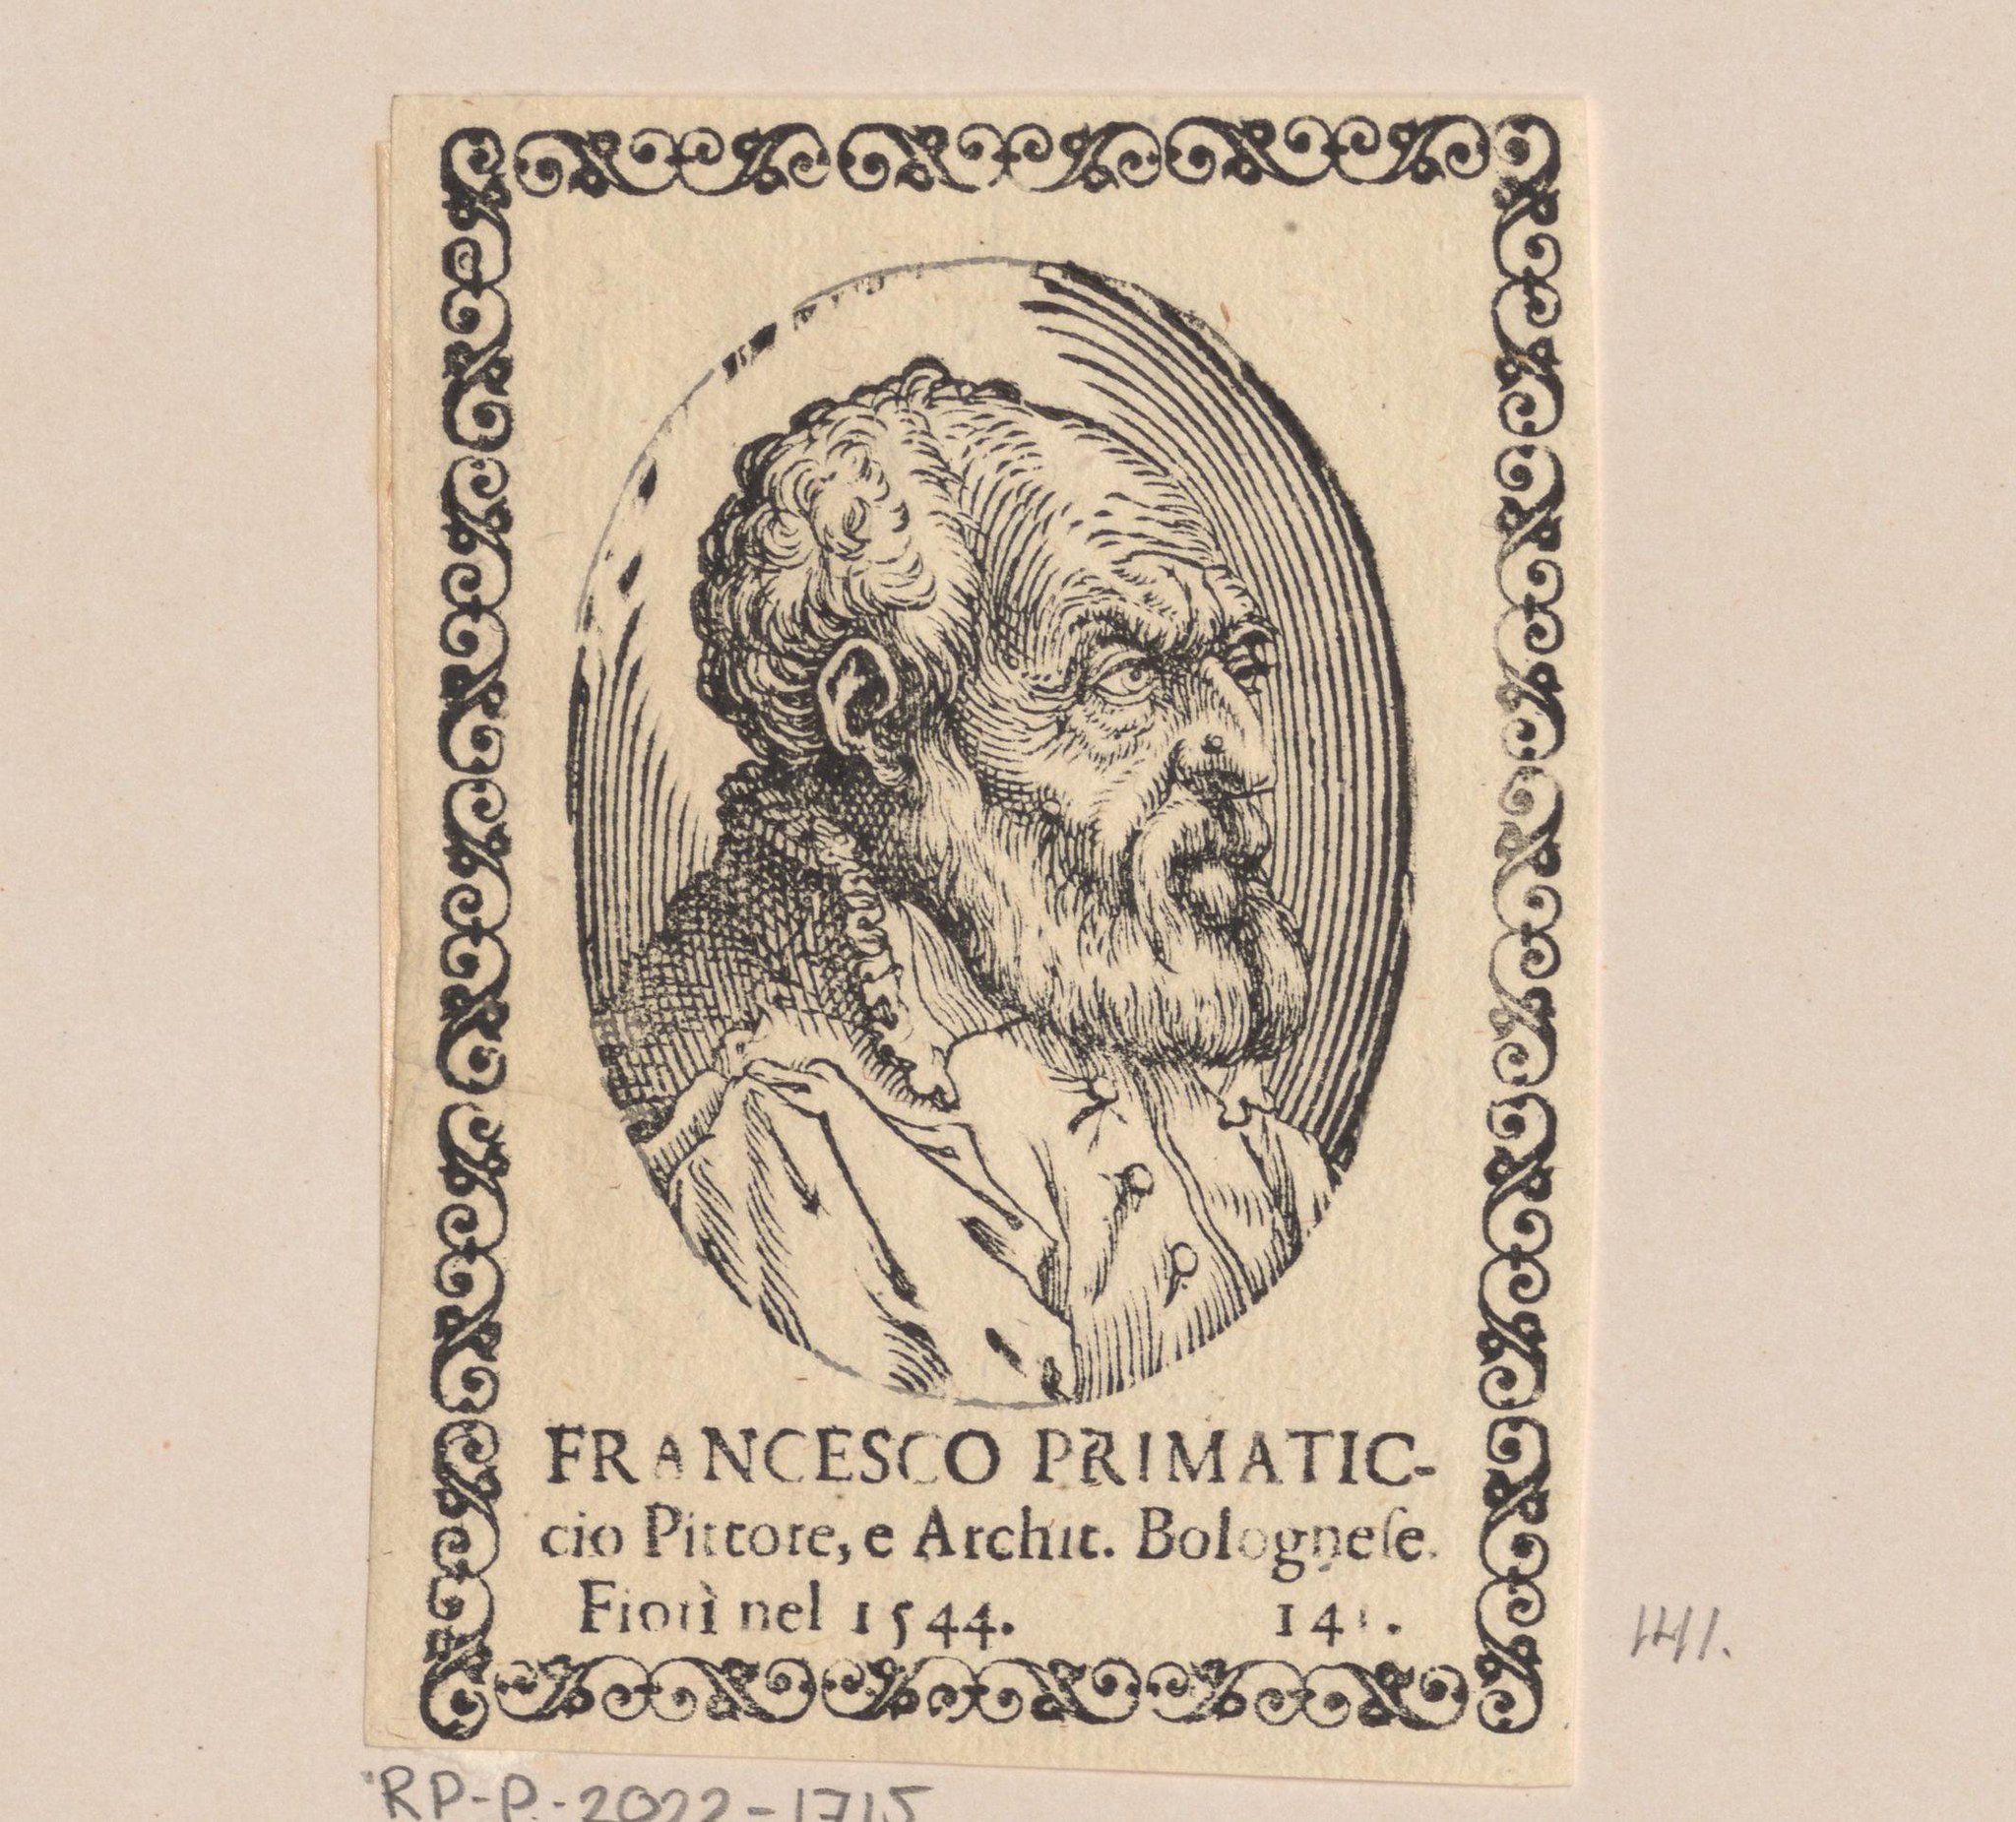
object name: print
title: Portret van Francesco Primaticcio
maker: cristoforo coriolano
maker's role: print maker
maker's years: 1540-1610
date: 1568-1650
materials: paper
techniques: letterpress printing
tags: paris, painter, draughtsman, sculptor, francesco primaticcio, historical persons, portrait, self-portrait of artist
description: Prent komt uit een editie van Vasari's 'Vite'. Prent met een andere omlijsting is gebruikt in de editie uit 1568: Vasari, Giorgio. Le vite de' piu eccellenti pittori scultori, e architettori. Florence: Filippo Giunta, 1568. En mogelijk in de editie uit 1647.